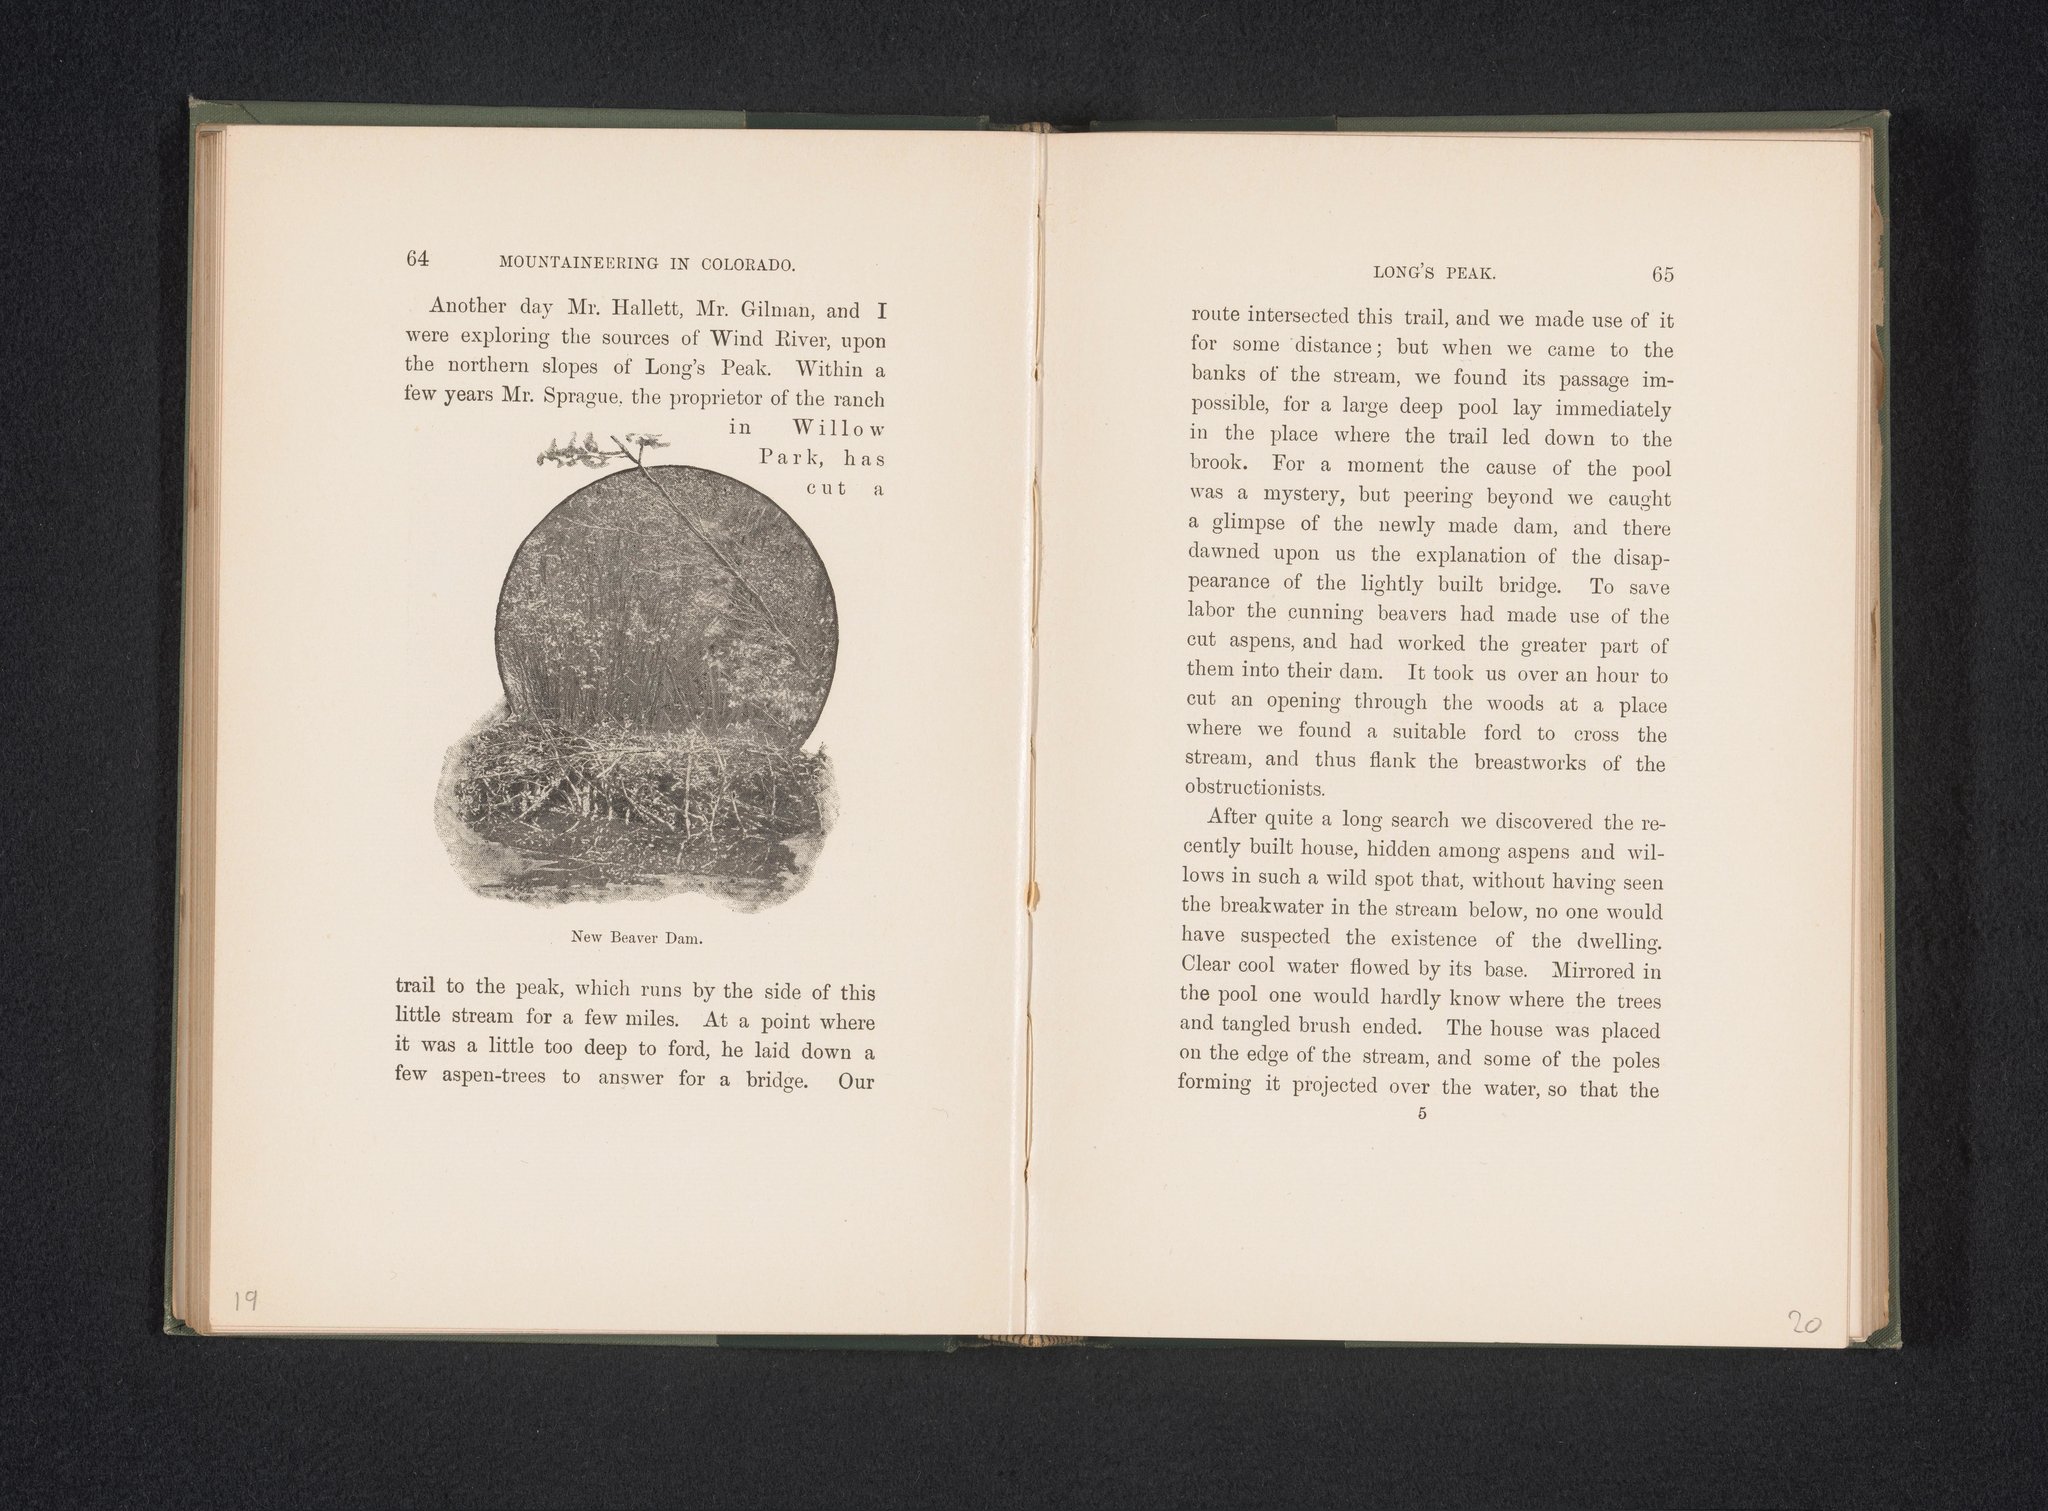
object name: page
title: Beverdam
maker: frederick hastings chapin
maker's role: antropoloog, archeoloog, fotograaf, schrijver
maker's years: 1852-1900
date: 1885-1890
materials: paper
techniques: autotype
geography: rocky mountain national park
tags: landscapes, wildlife reserve, national park